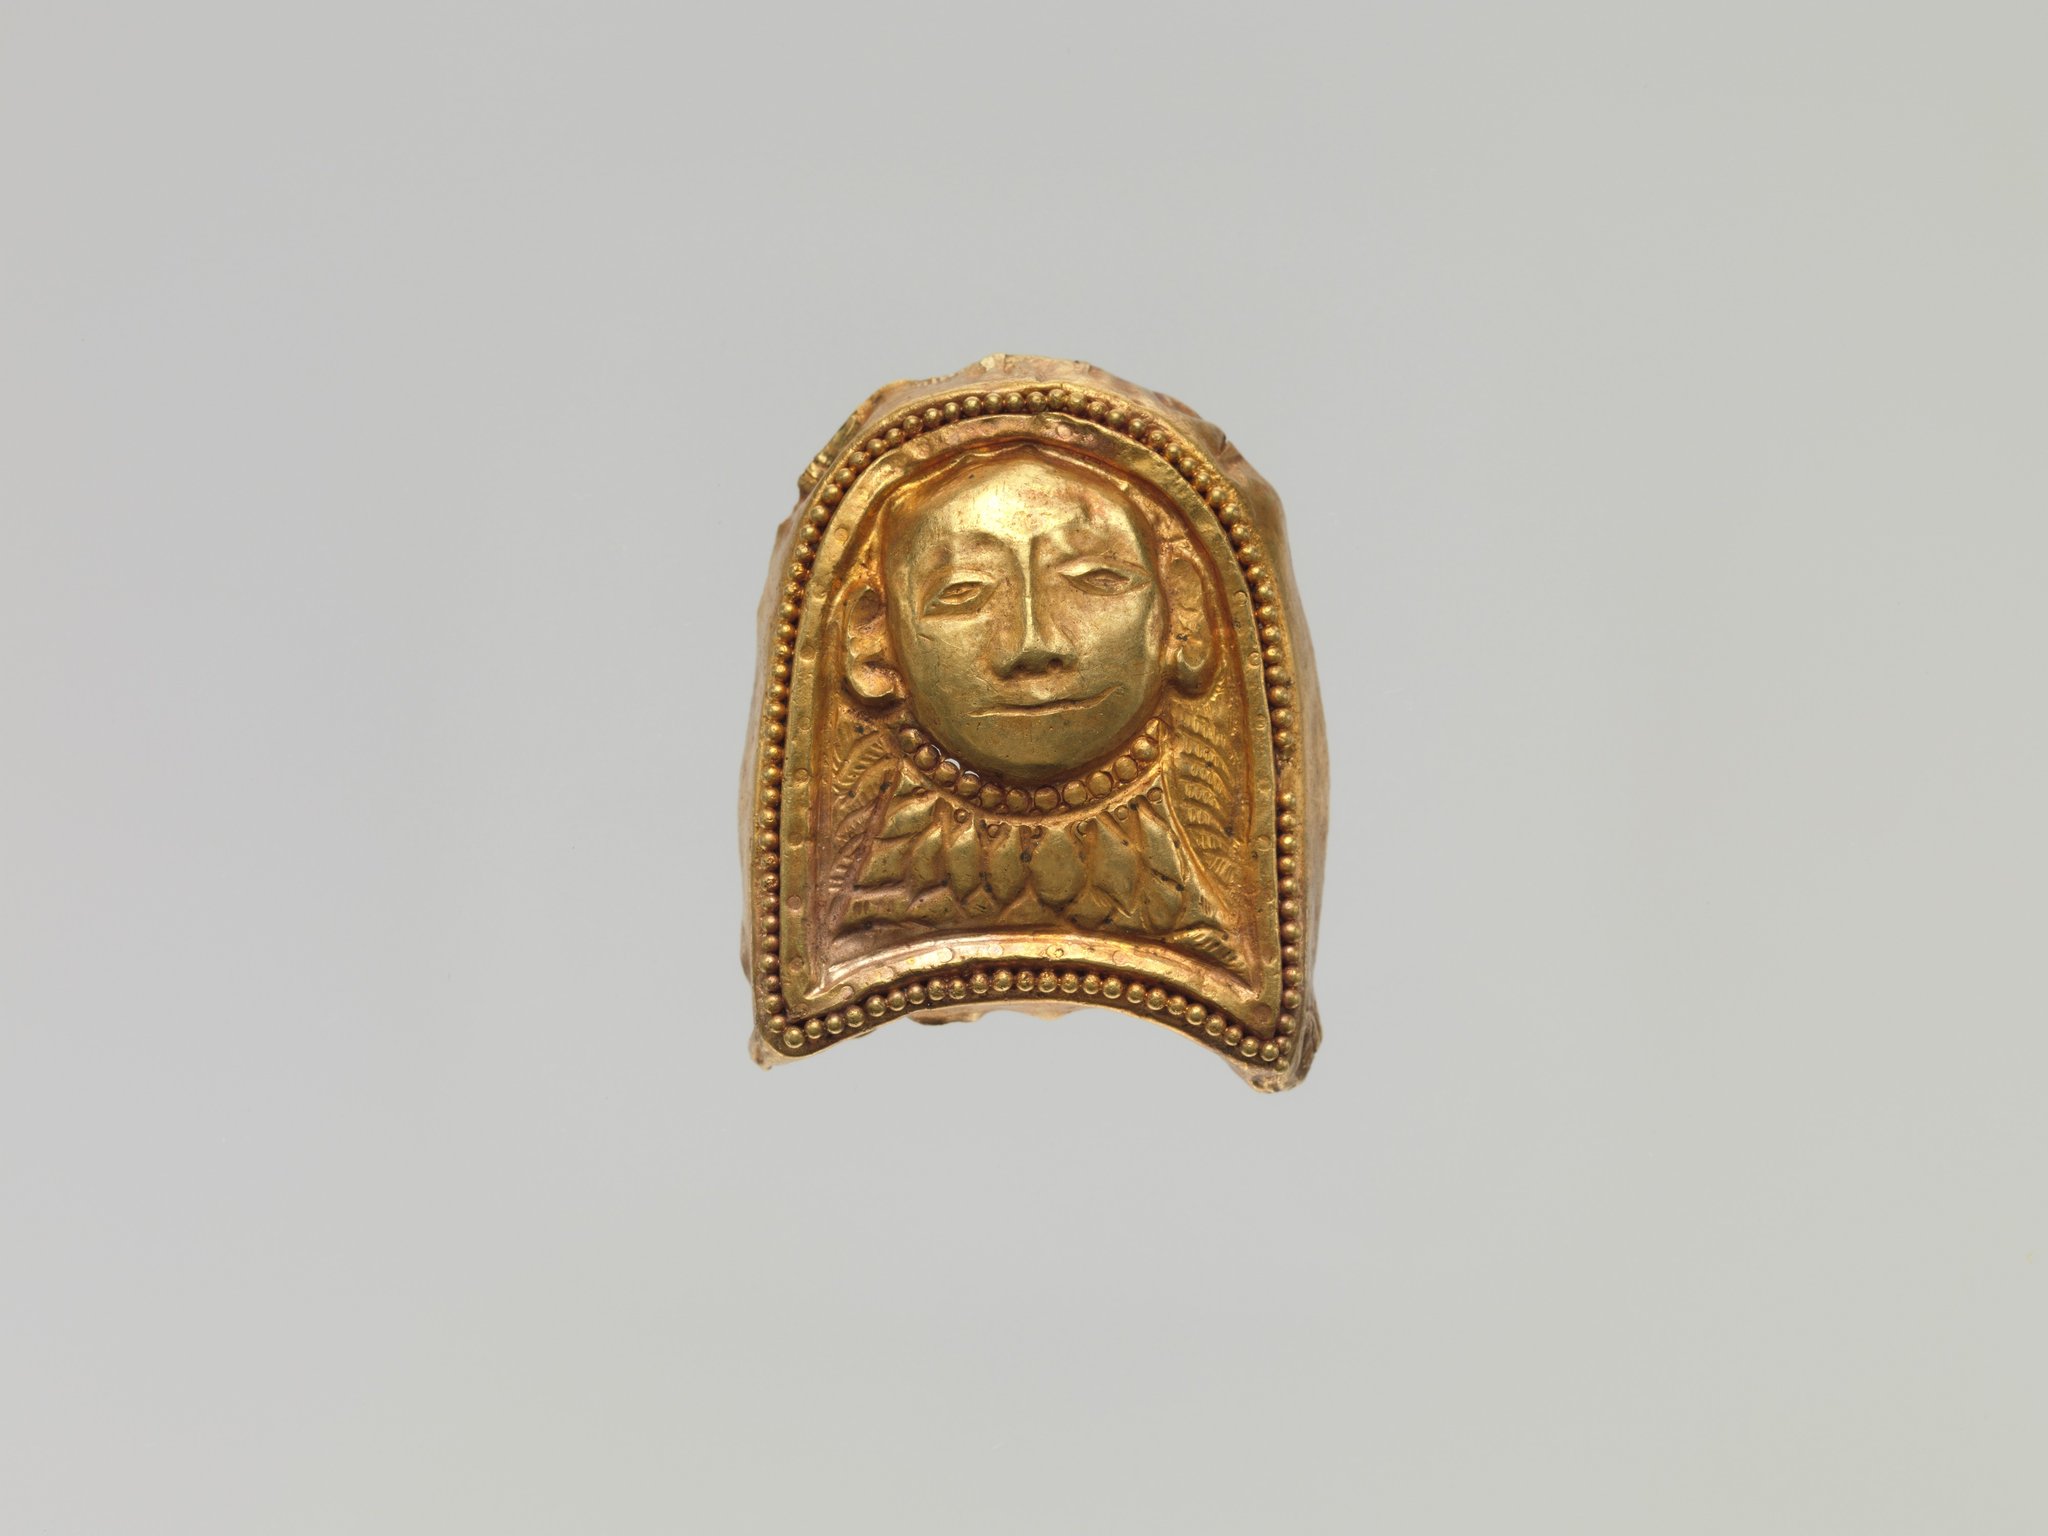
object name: plaque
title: Plaque with Head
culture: chinese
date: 601-900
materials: gold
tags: heads